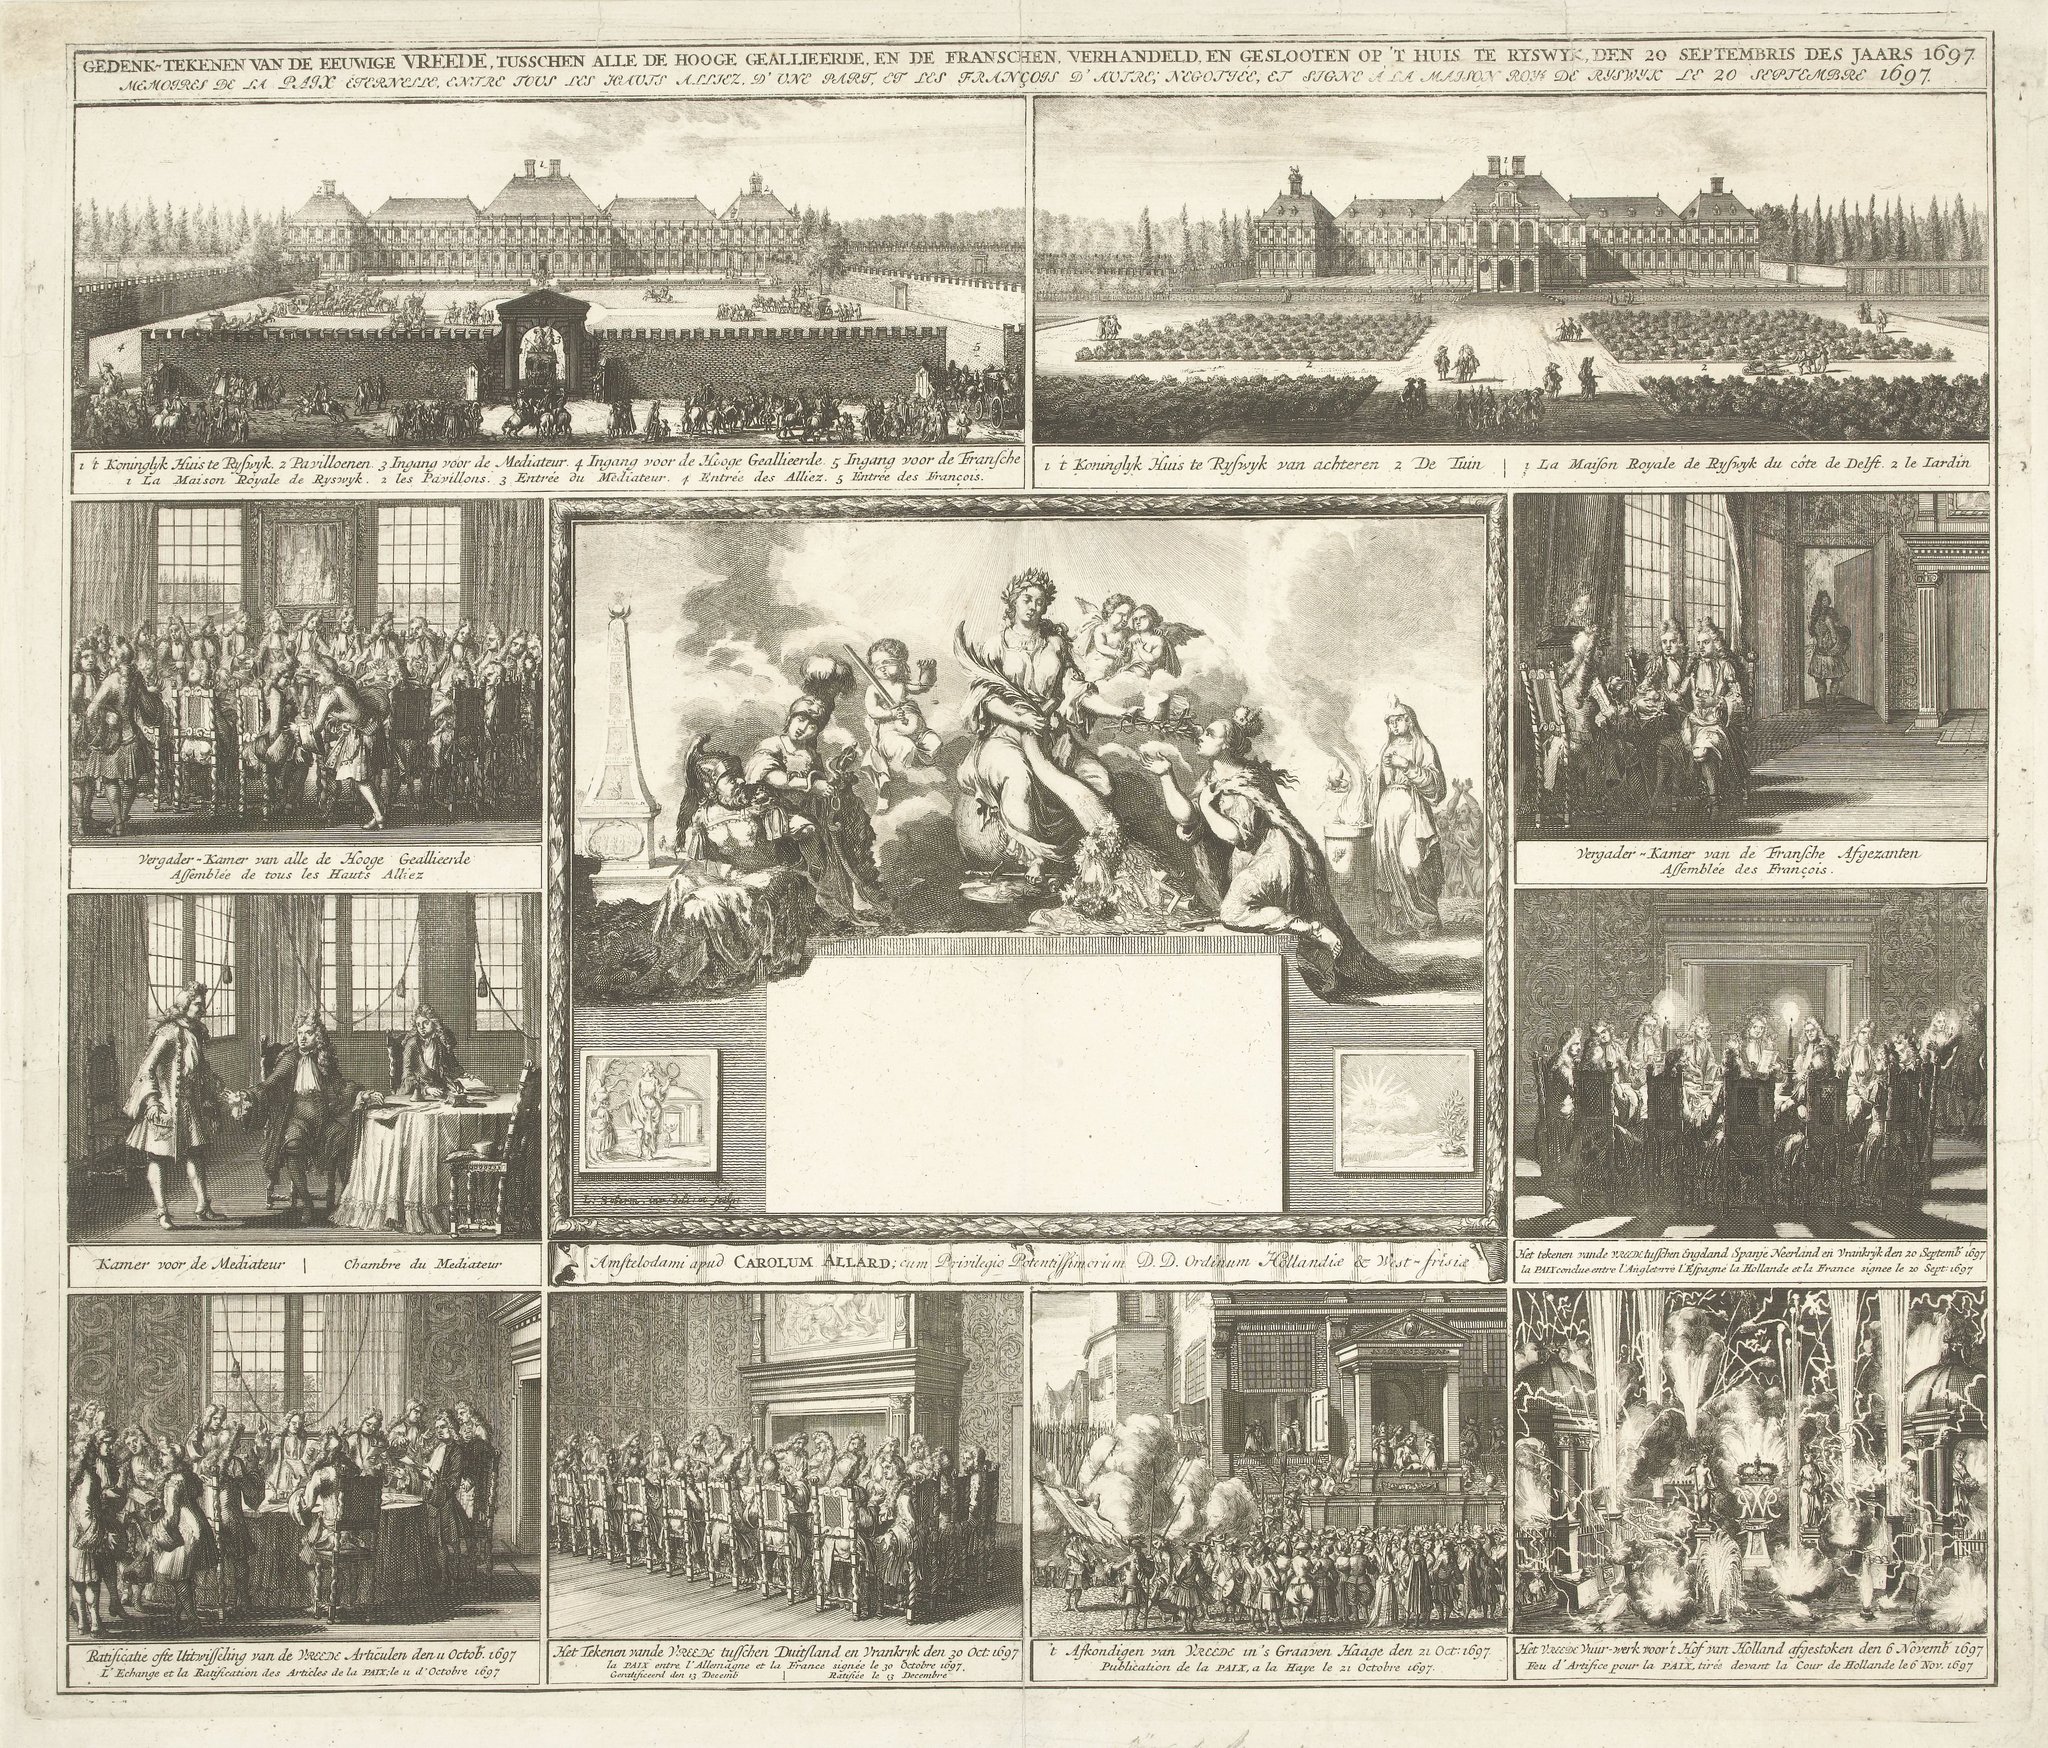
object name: print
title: Gedenkteken van de Vrede van Rijswijk, 1697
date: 1698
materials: paper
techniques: etching, letterpress printing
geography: amsterdam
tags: peace negotiations, proclamation of peace, bonfire, fire-works, signing of peace treaty, concluding the peace, the hague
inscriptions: collector's mark: Lugt 2228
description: Gedenkteken van de Vrede van Rijswijk, gesloten op 20 september 1697 in het Huis te Nieuburch in Rijswijk. Centraal een allegorische voorstelling met een blanco paneel, omringd door kleinere voorstellingen van het huis te Rijswijk, de vredesonderhandelingen, de bekendmaking van de vrede en de viering van de vrede met vuurwerk te Den Haag. Bij de prent behoort een apart tekstblad met een verklaringen in het Nederlands en Frans.